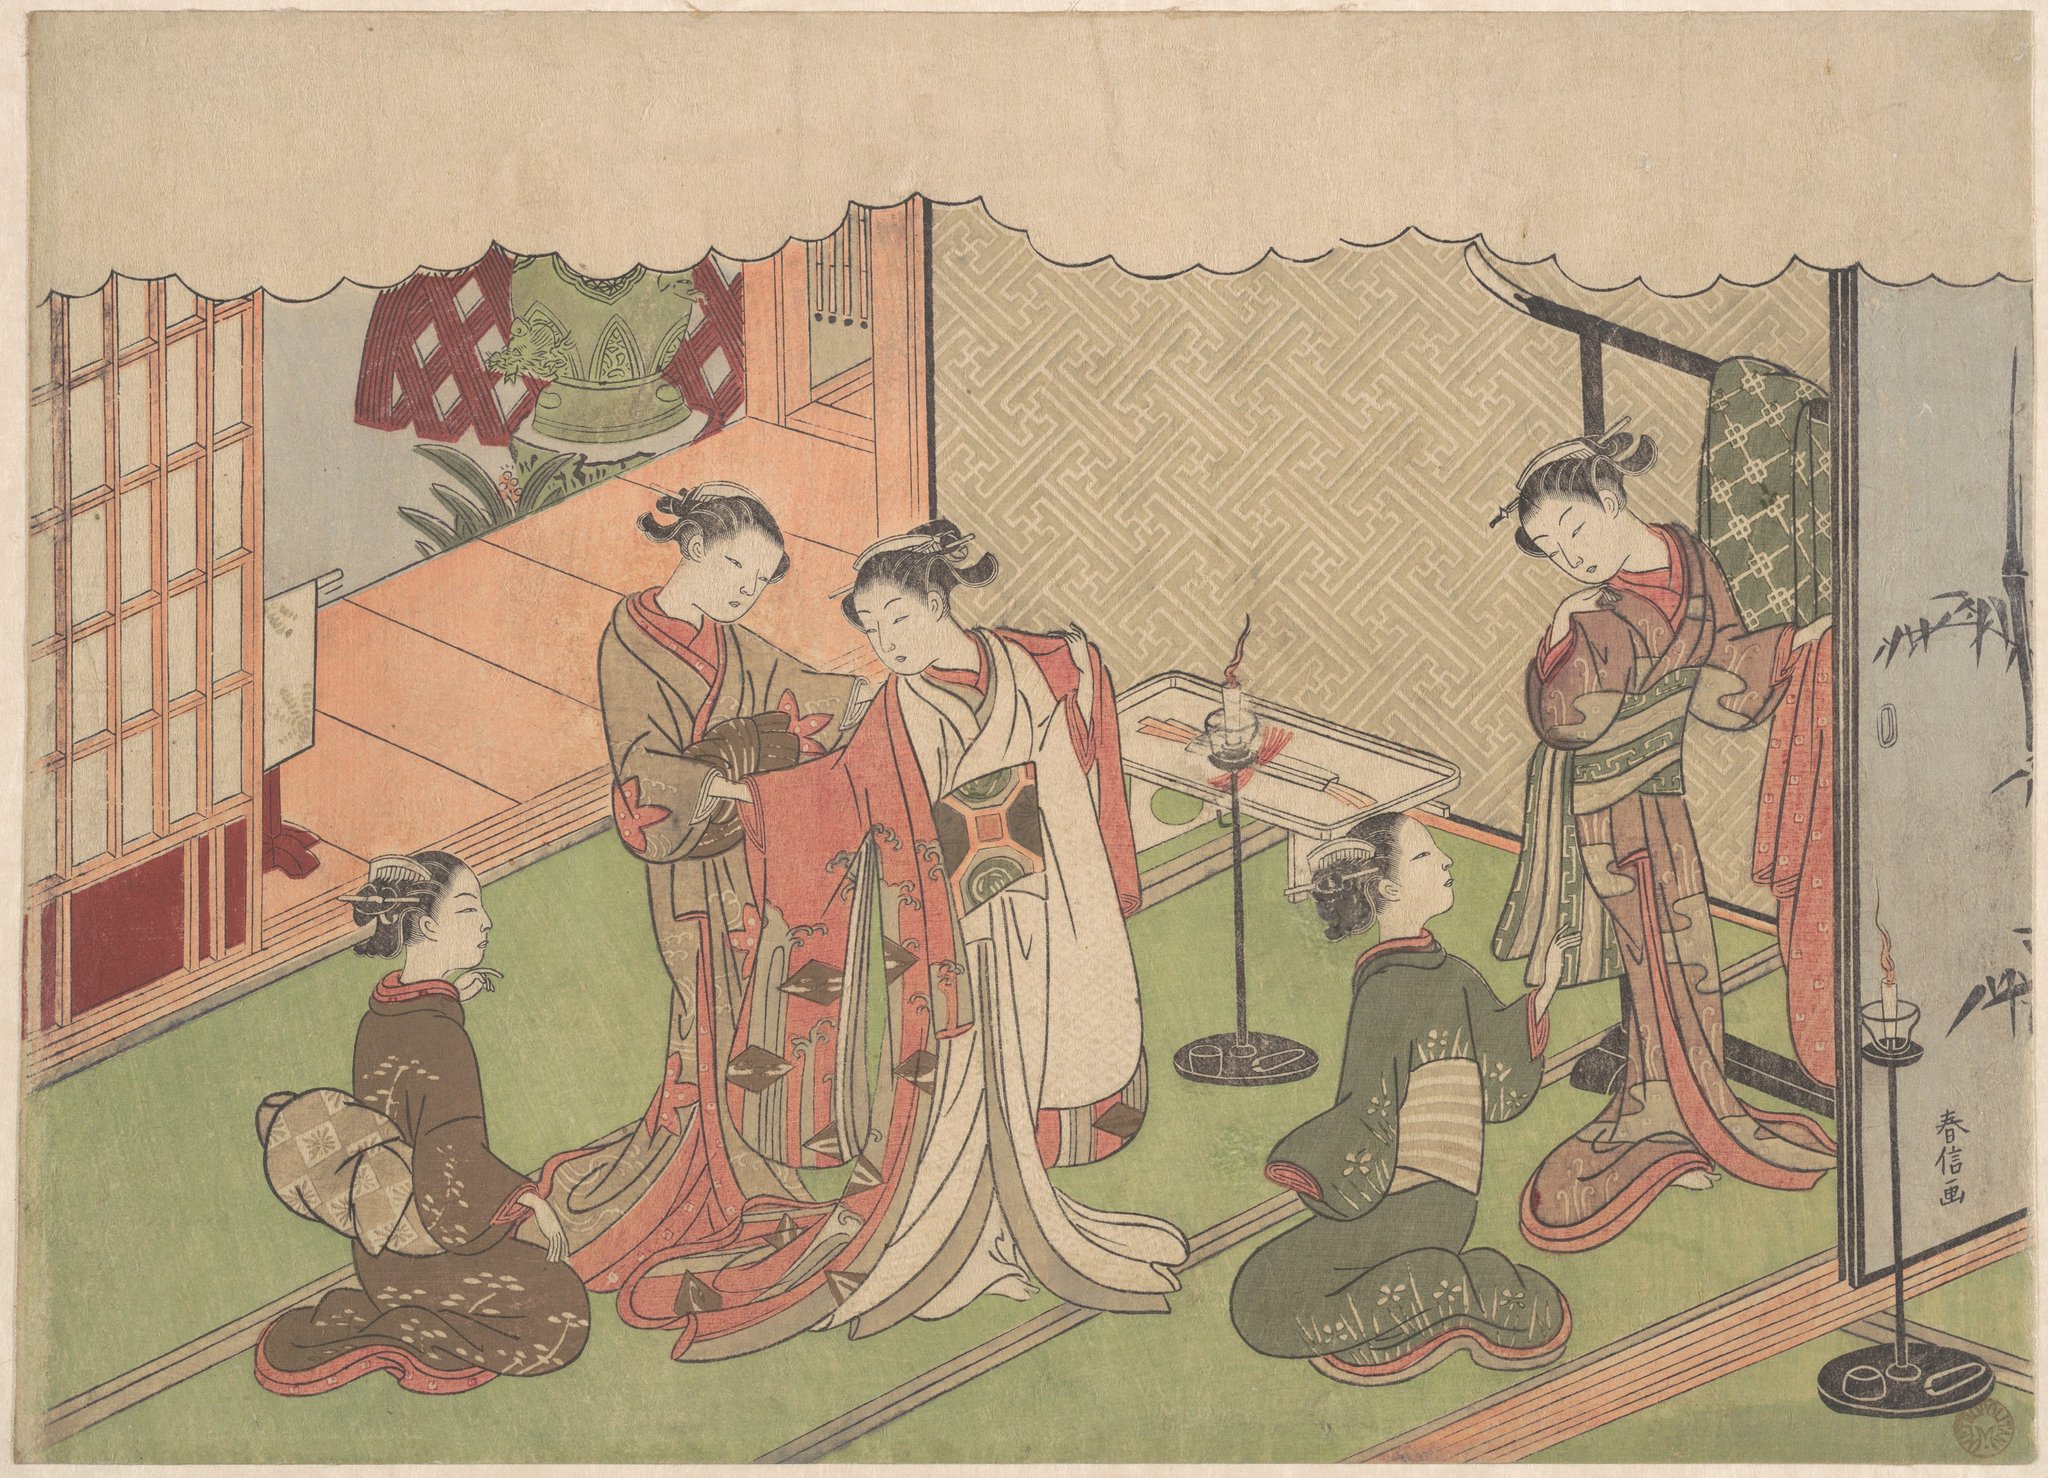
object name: print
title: The Marriage Ceremony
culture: japanese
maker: suzuki harunobu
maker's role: artist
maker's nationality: japanese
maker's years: 1725-1770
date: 1768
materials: ink, paper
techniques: woodblock print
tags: women,ceremony,dressing